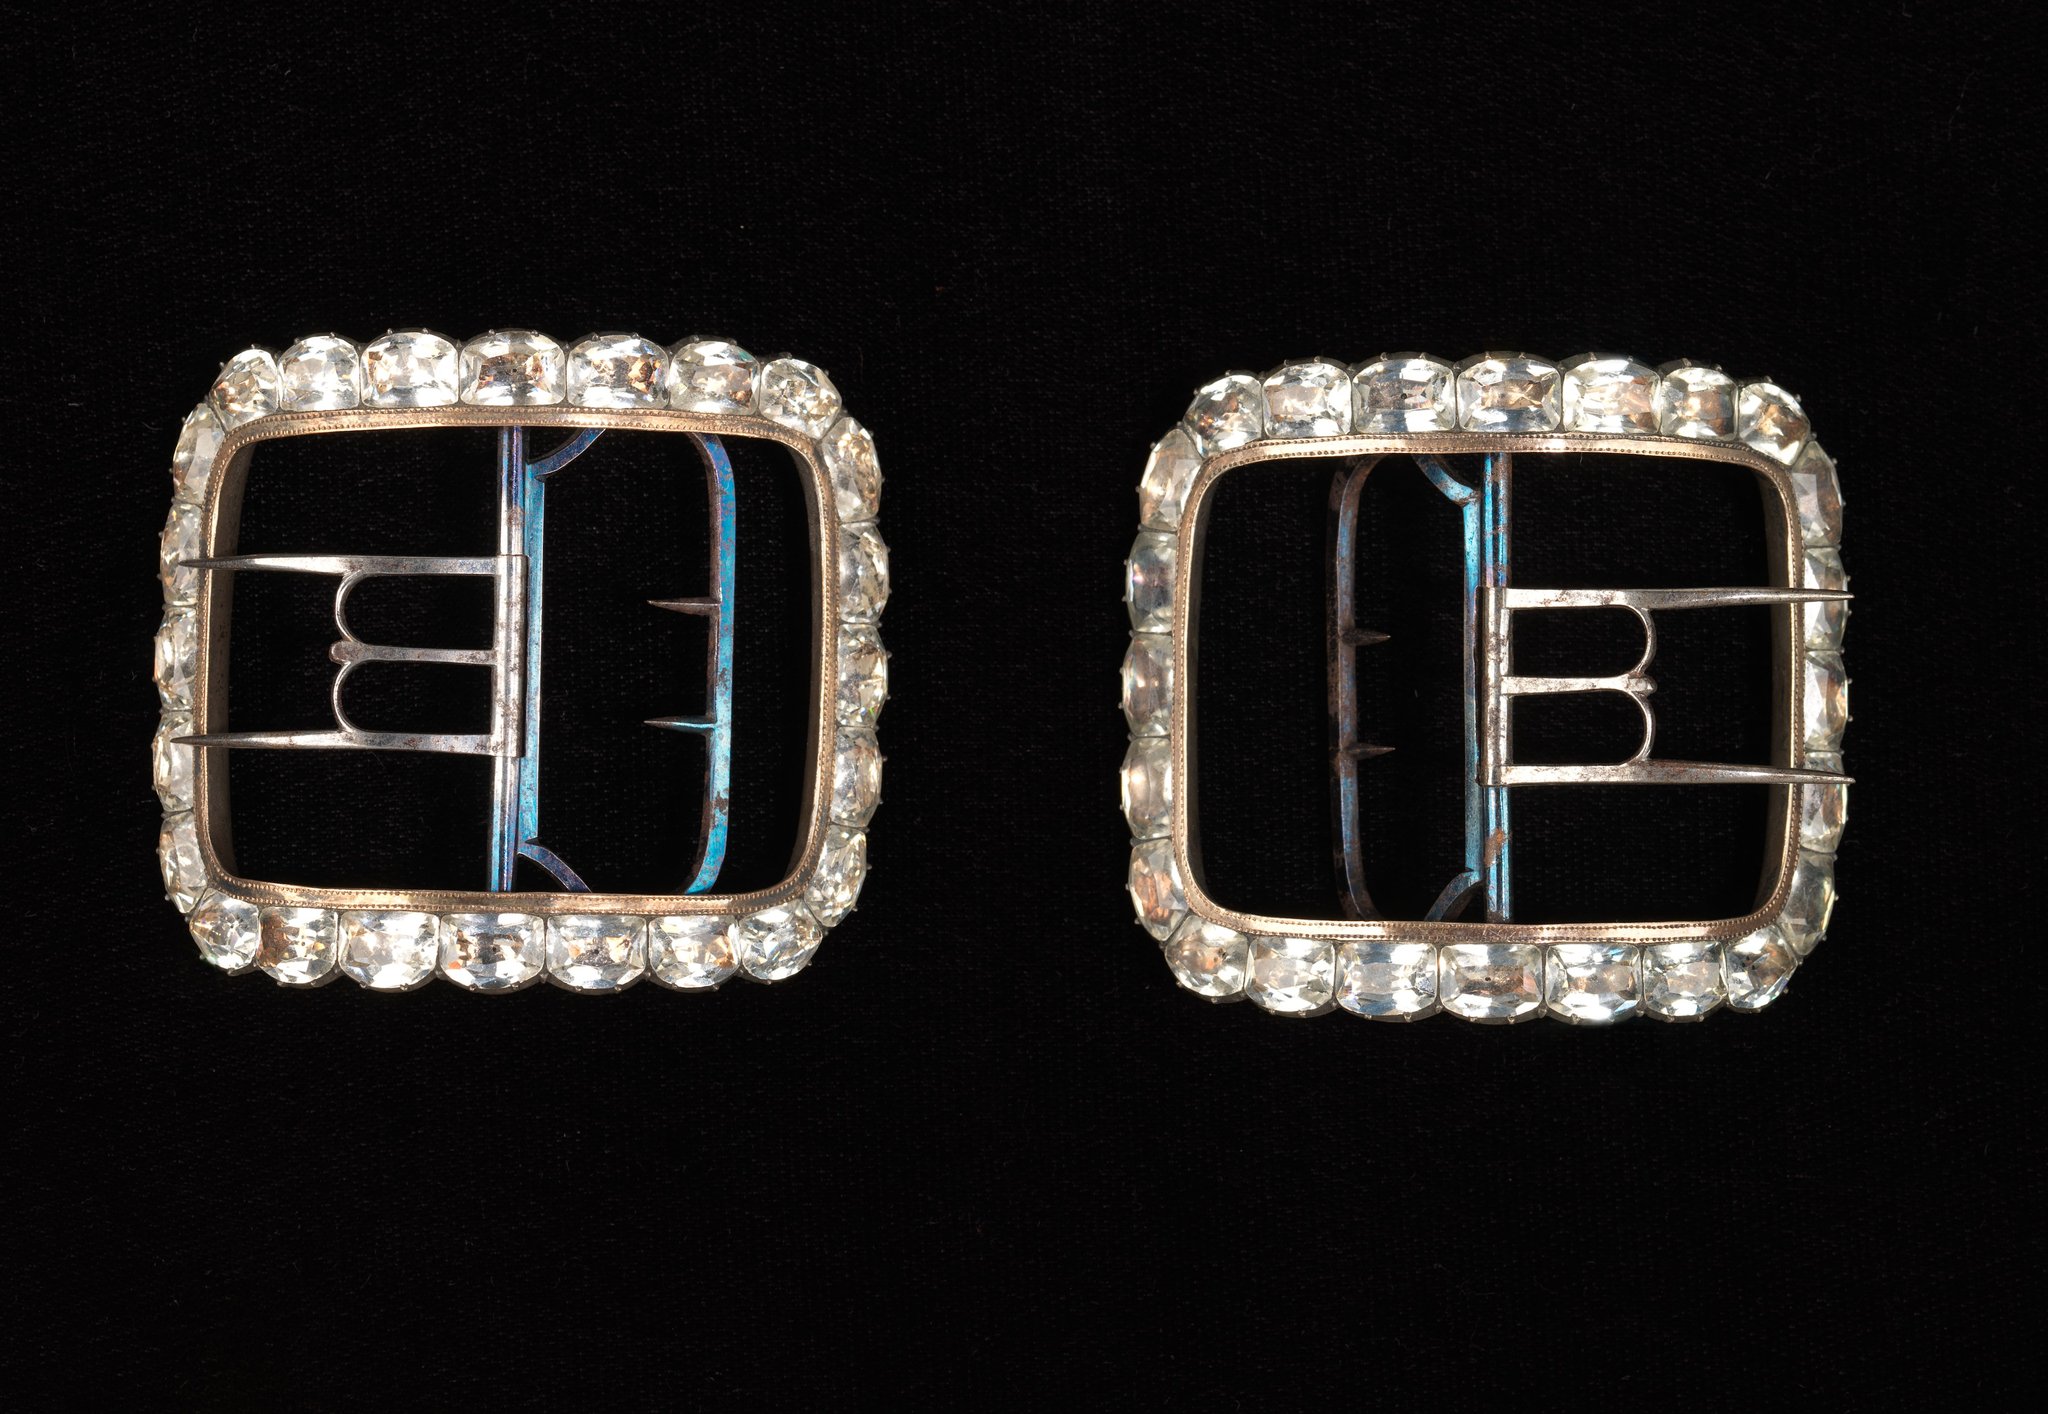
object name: shoe buckle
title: Shoe buckles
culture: british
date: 1780-1789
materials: glass, metal